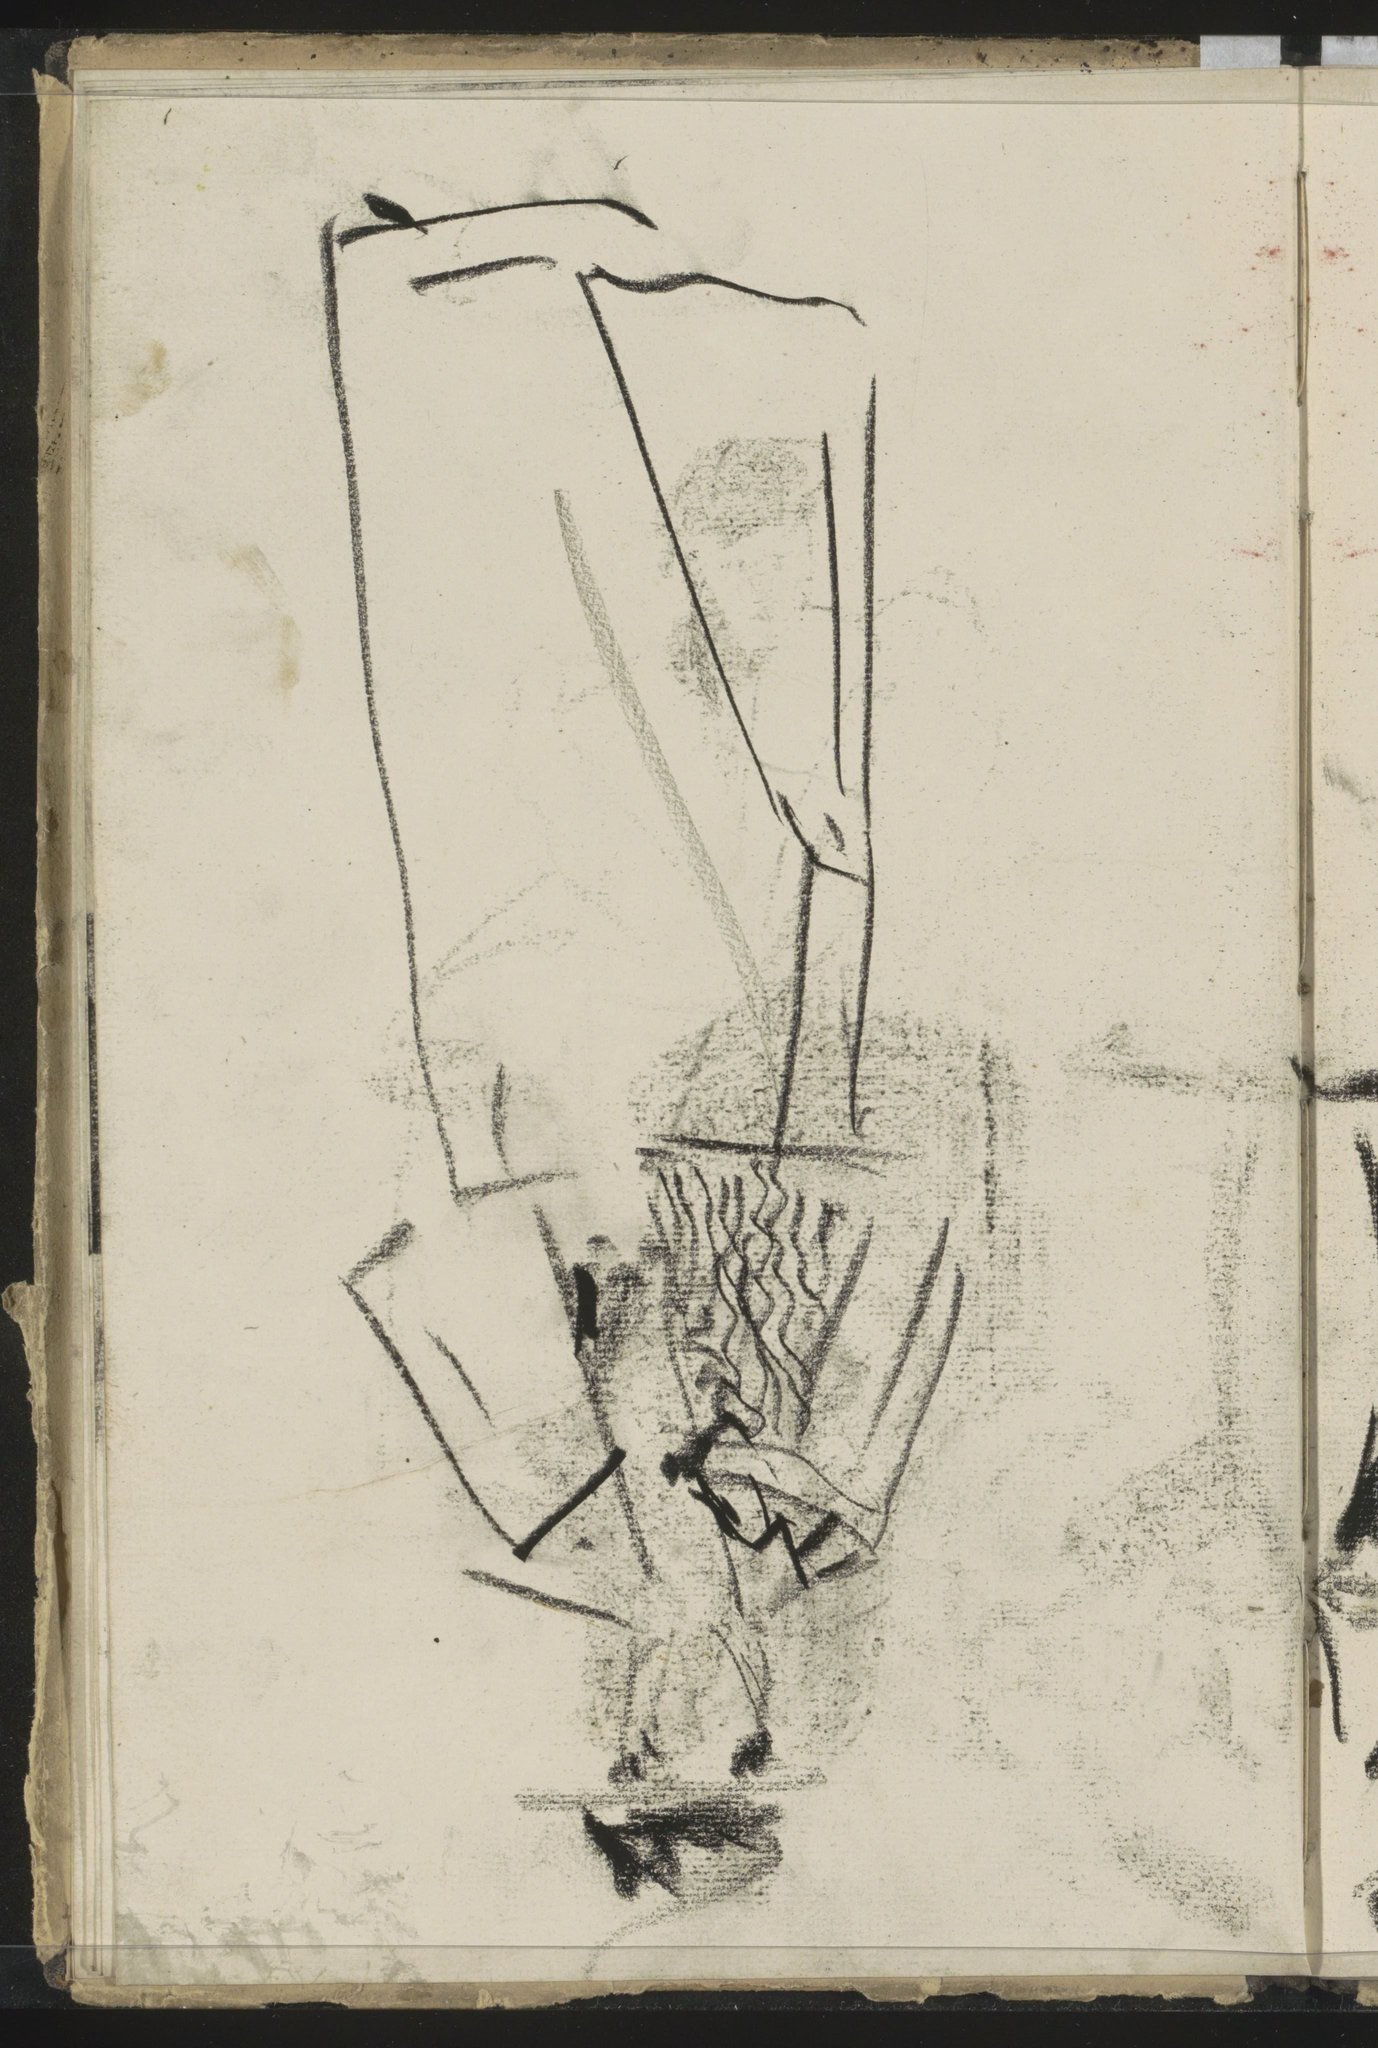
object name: sketchbook leaf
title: Staande vrouw met een hoed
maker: carel adolph lion cachet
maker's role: draughtsman, print maker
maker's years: 1864-1945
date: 1890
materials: chalk, paper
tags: standing figure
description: Blad 5 verso uit een schetsboek met 38 bladen.